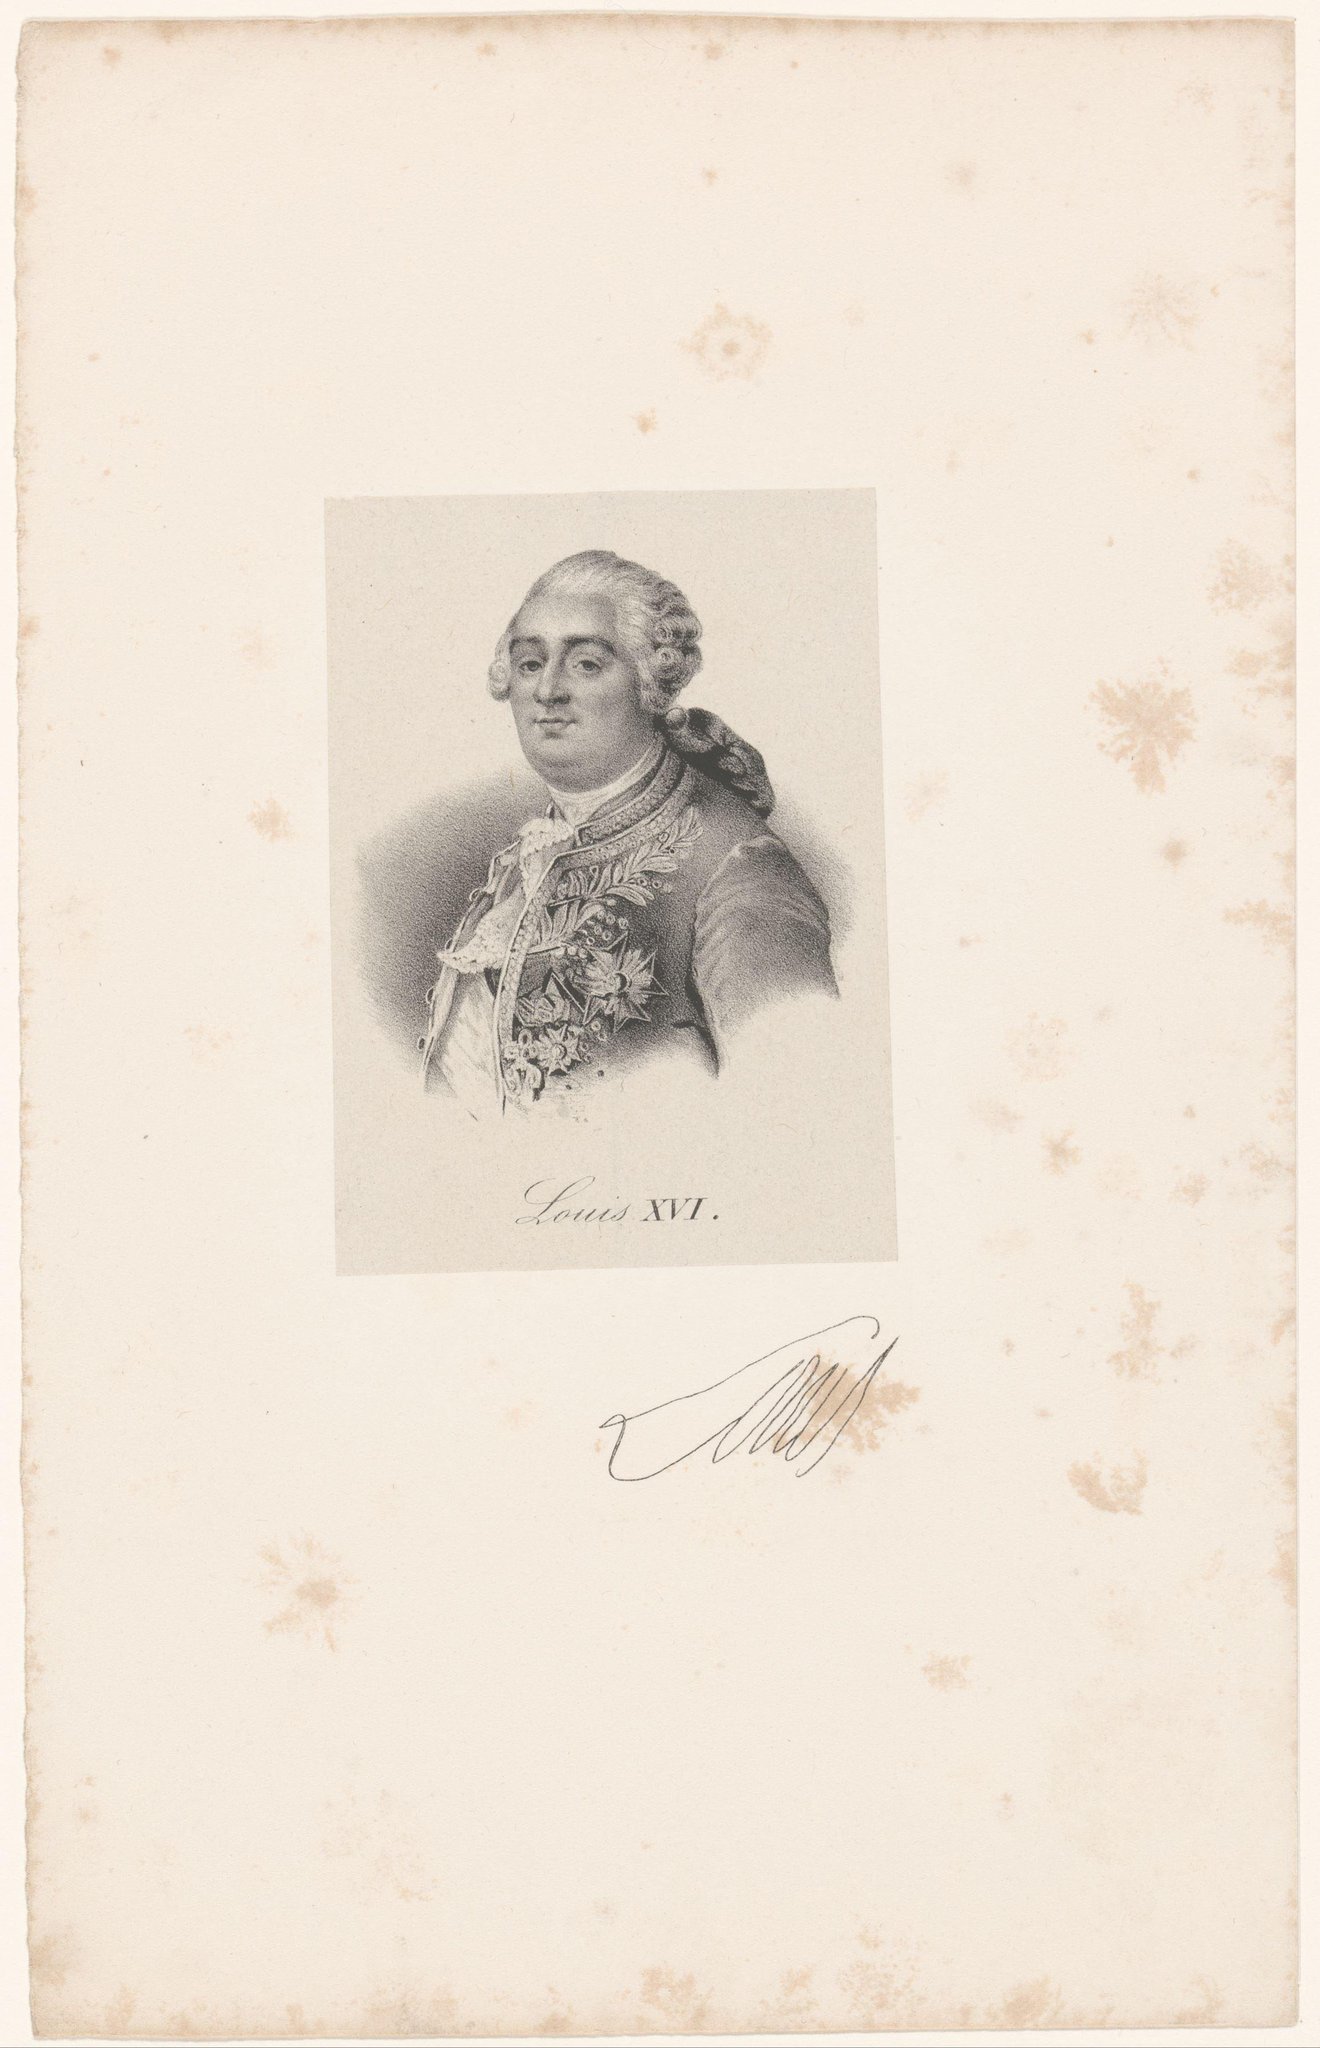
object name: print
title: Louis XVI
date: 1818-1842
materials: paper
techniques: lithograph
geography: paris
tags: paris, lodewijk xvi (koning van frankrijk), historical persons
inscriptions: collector's mark: Lugt 2228a